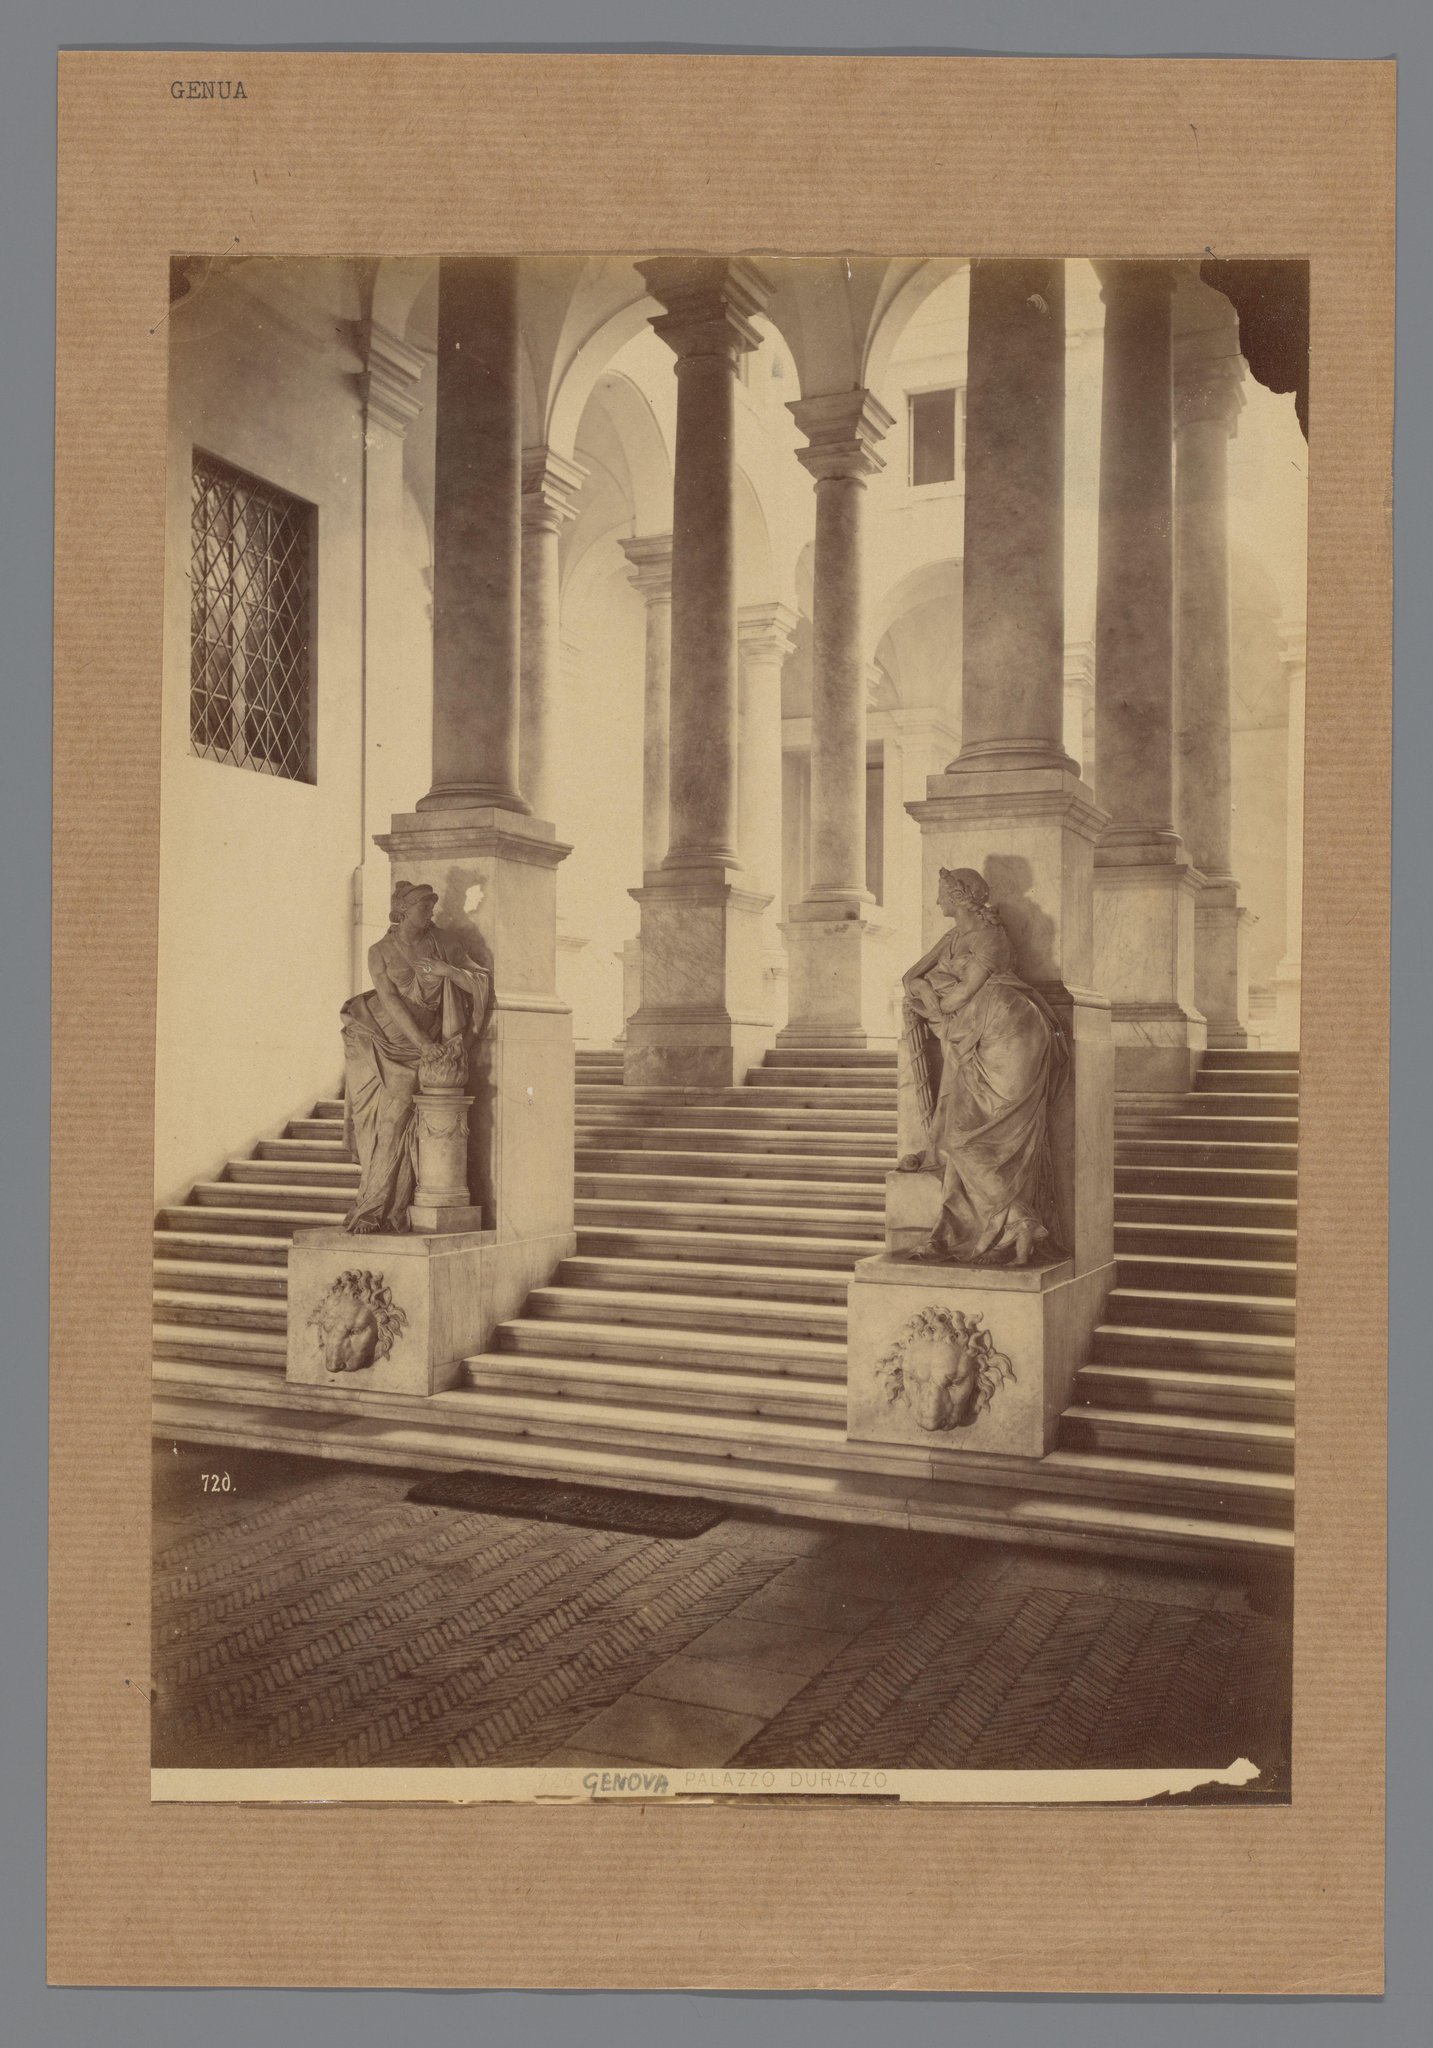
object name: photograph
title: Italië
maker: Anonymous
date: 1880-1910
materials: photographic support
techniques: albumen print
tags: italy